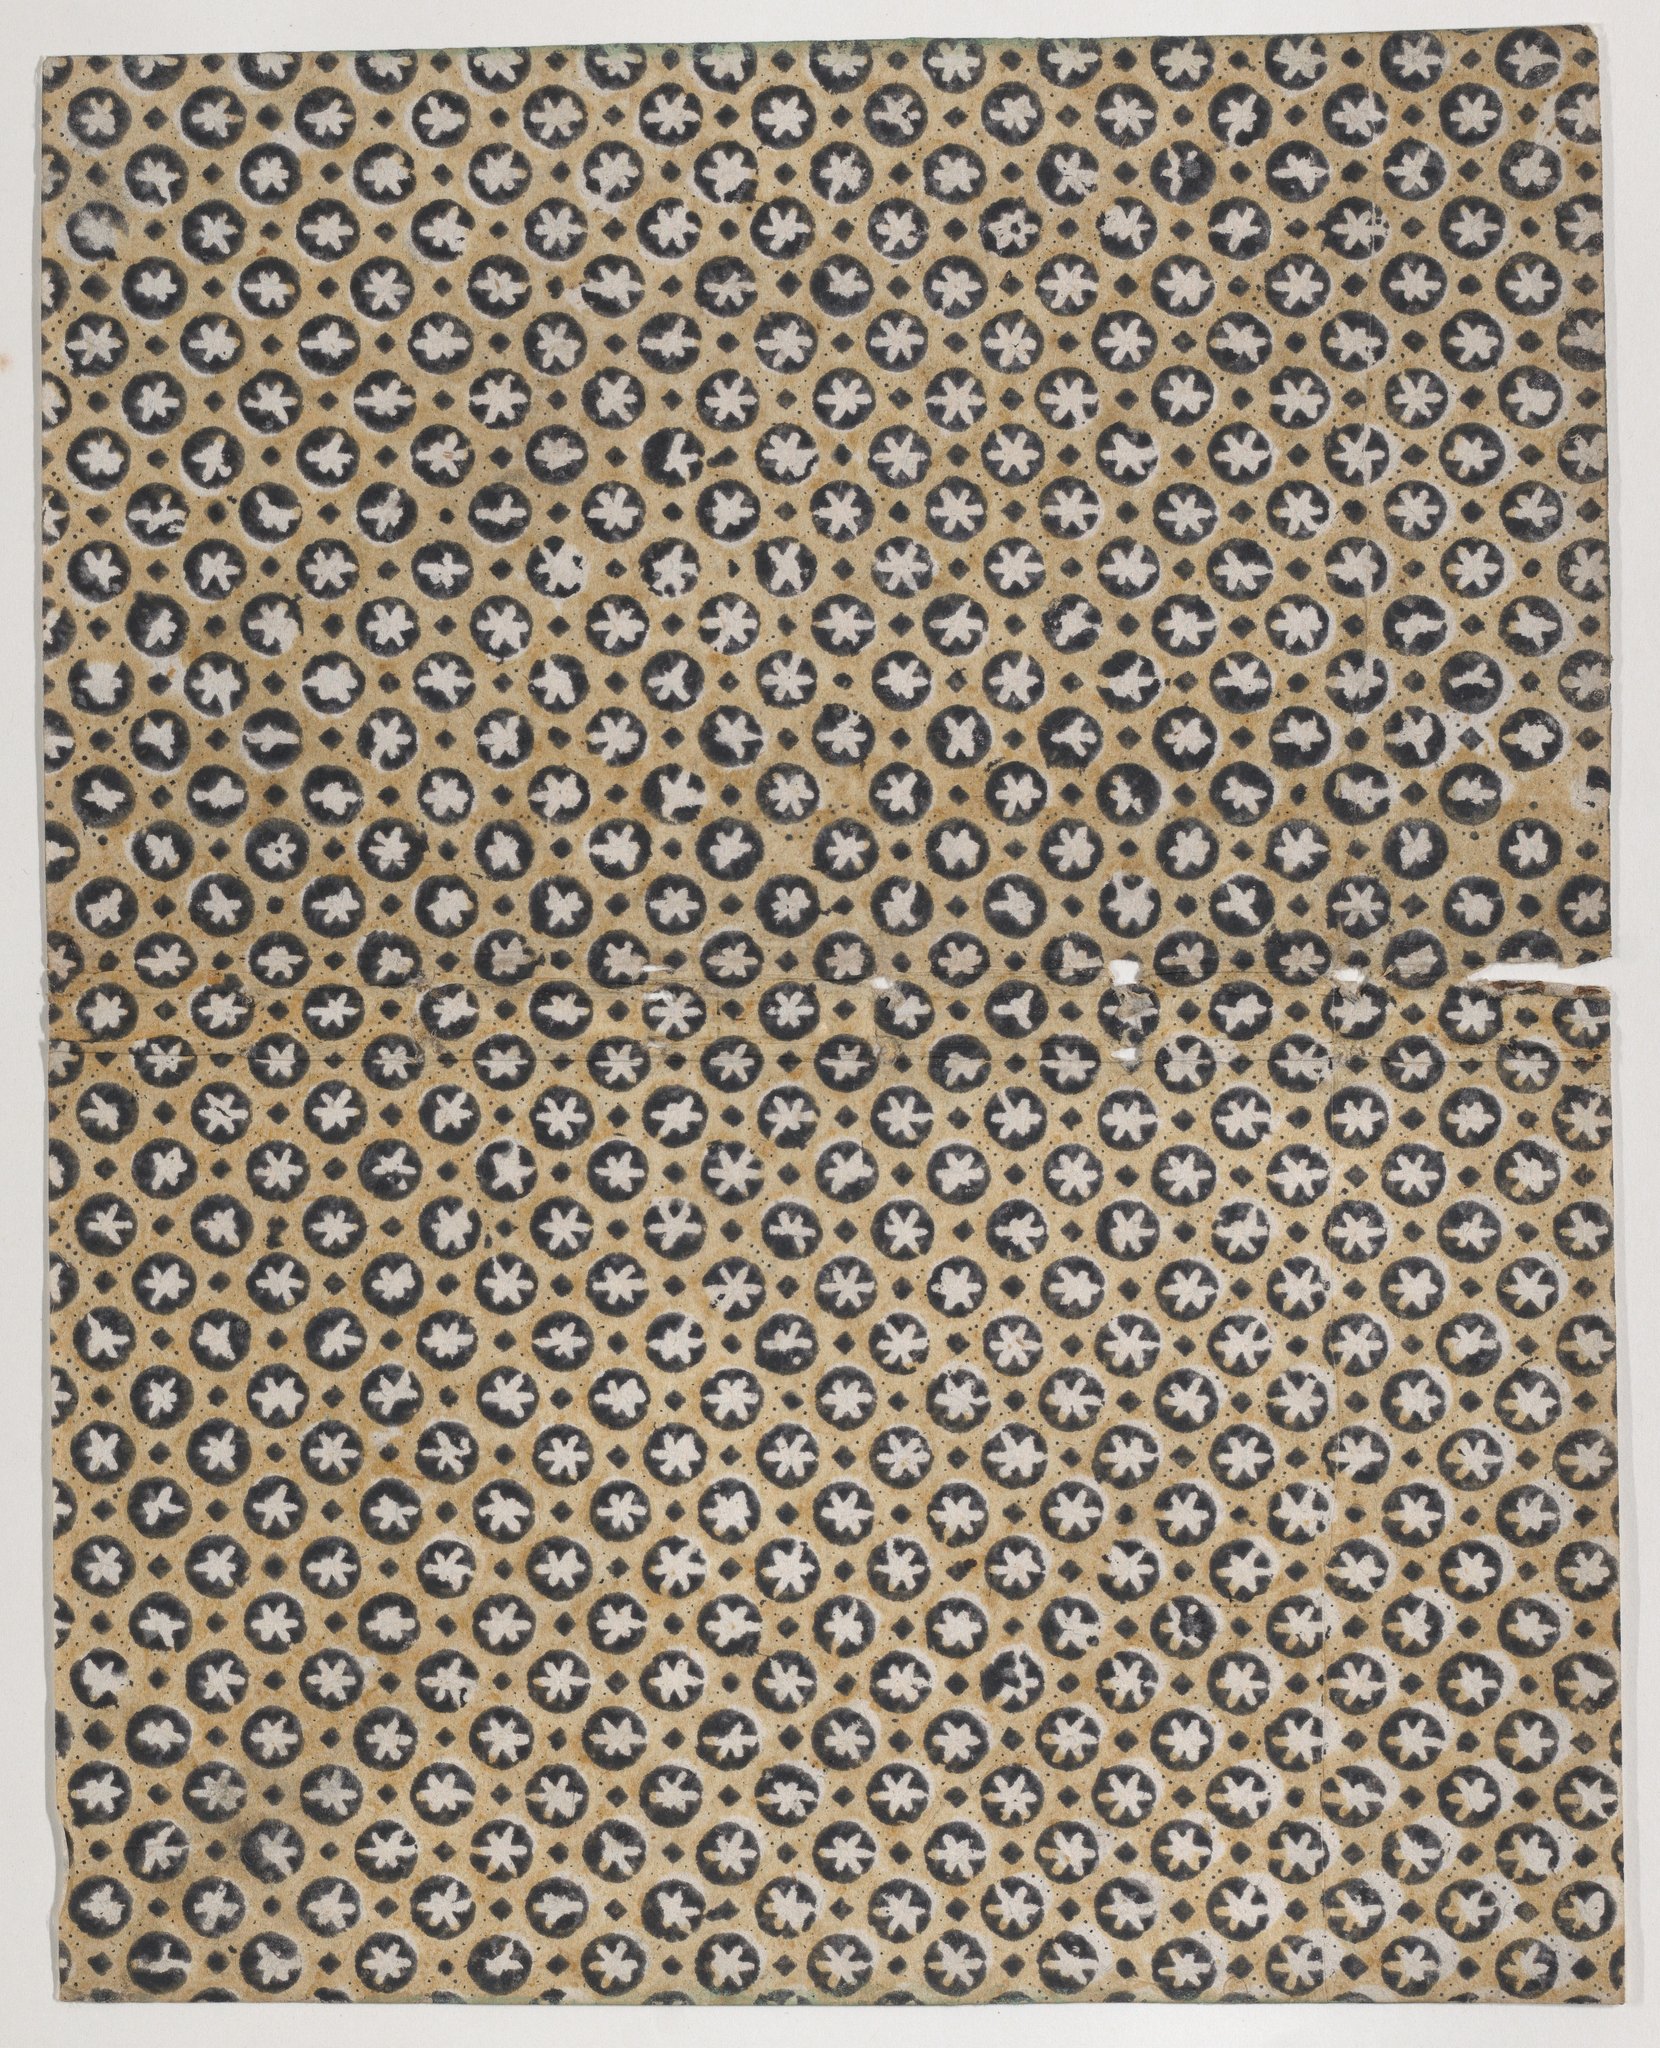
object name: print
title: Book cover with overall star pattern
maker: Anonymous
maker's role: artist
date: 1801-1900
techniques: relief print